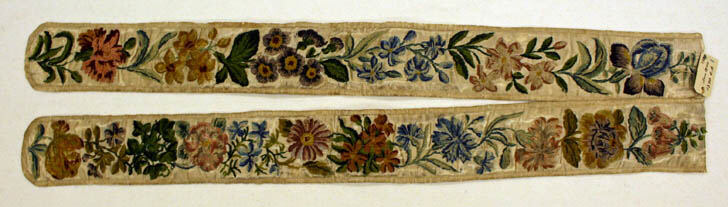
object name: suspender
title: Suspenders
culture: french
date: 1850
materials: silk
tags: plants